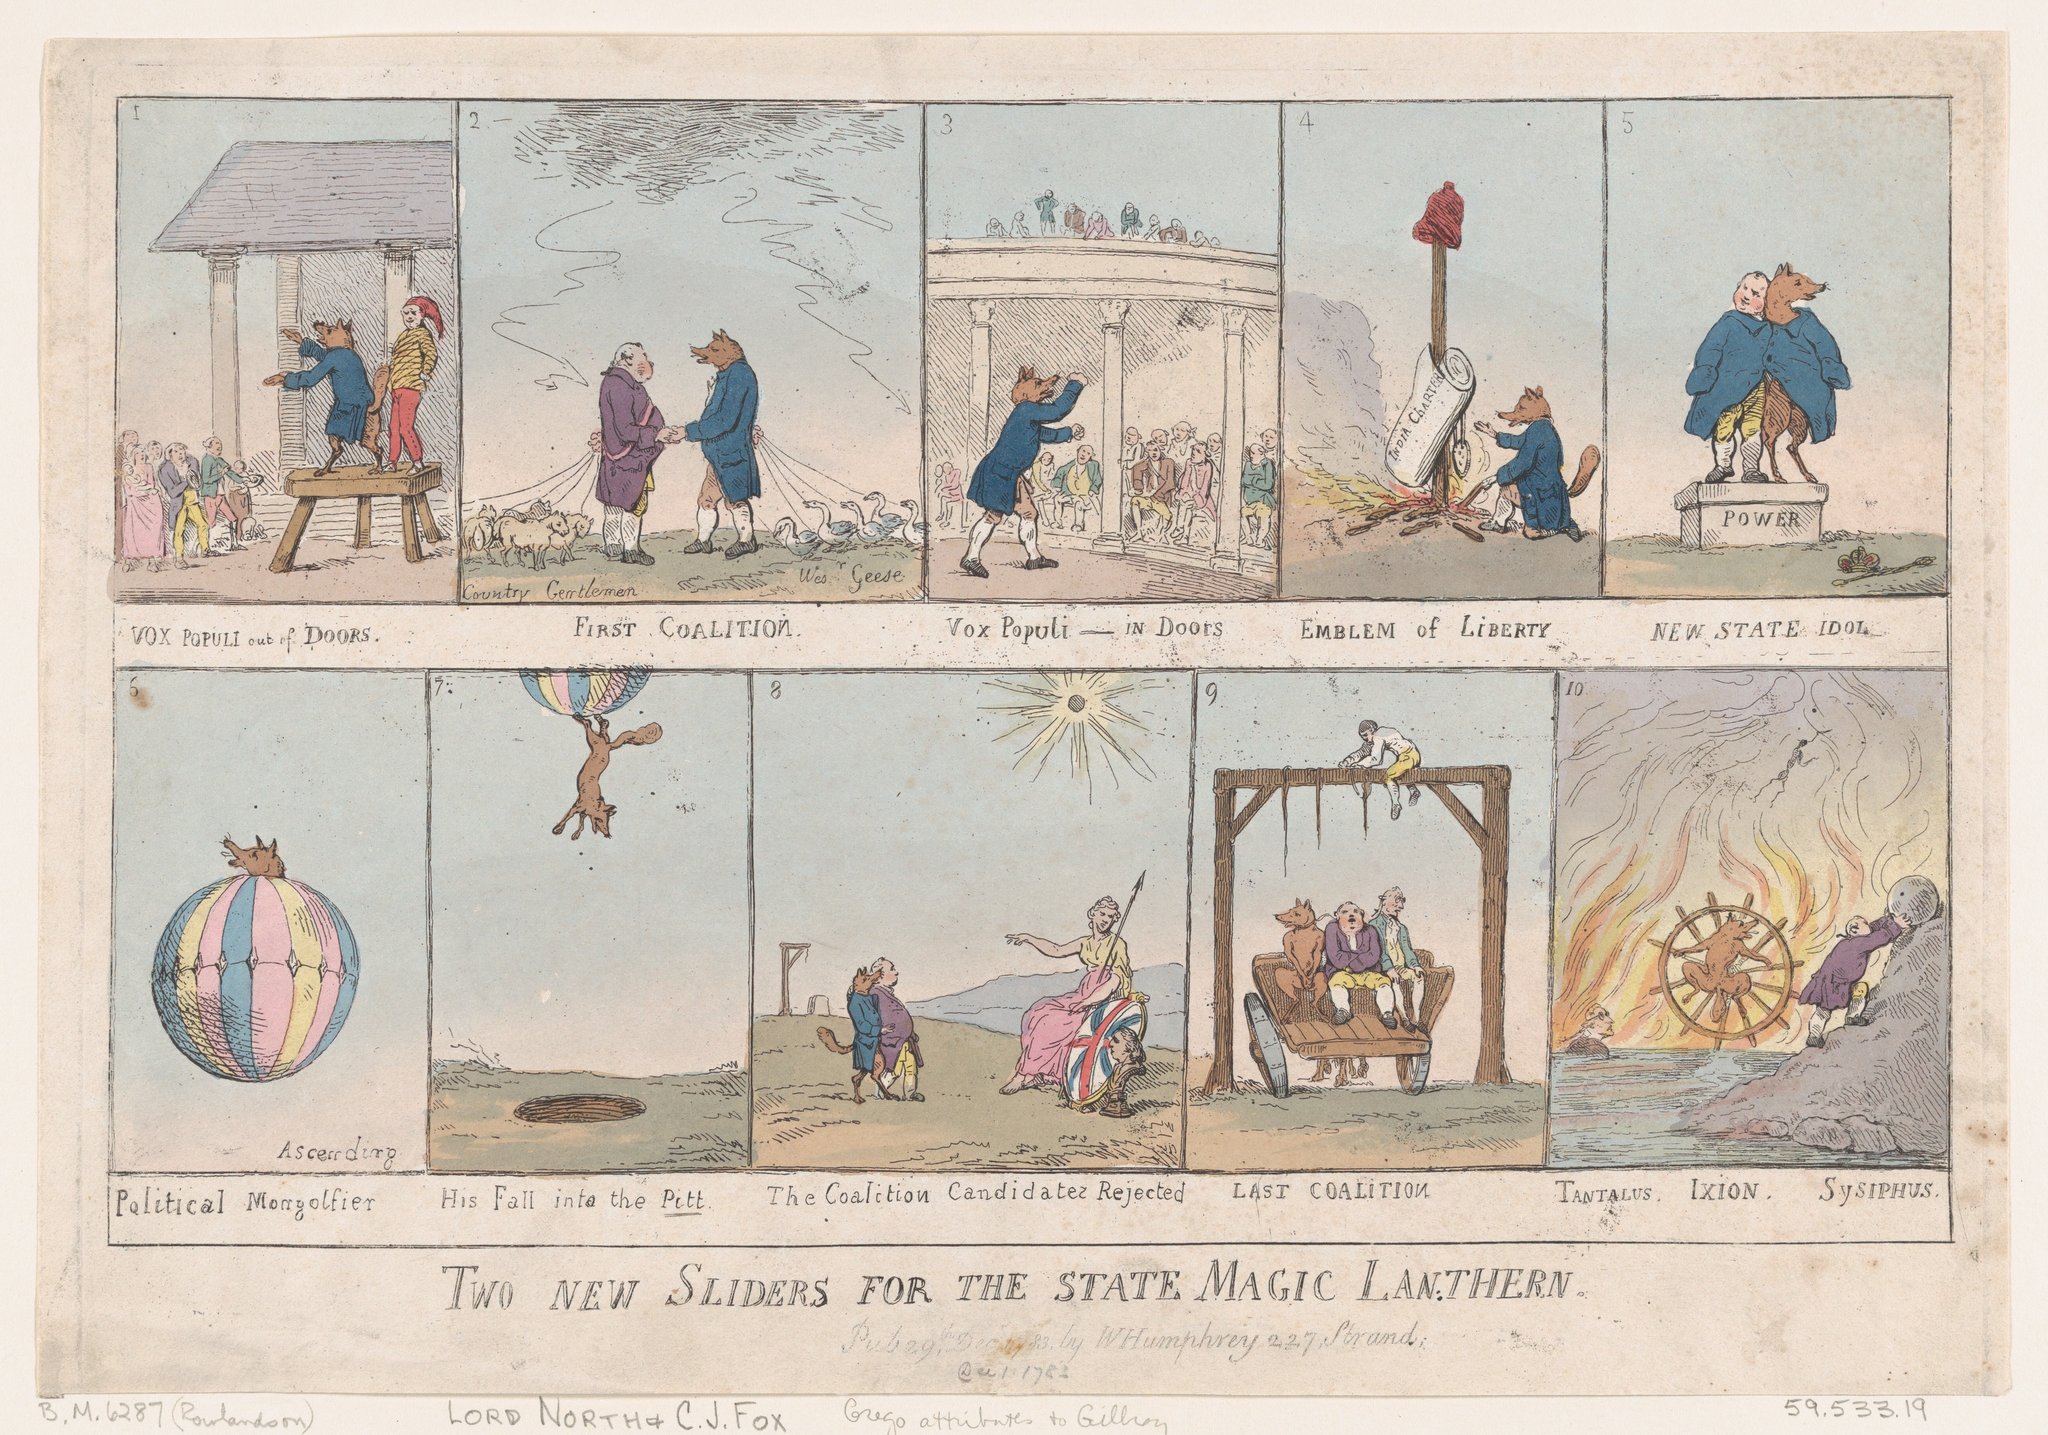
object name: print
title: Two New Slides for the State Magic Lantern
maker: thomas rowlandson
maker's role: artist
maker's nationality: british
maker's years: 1757-1827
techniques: etching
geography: london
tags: animals,satire,men,women,caricature